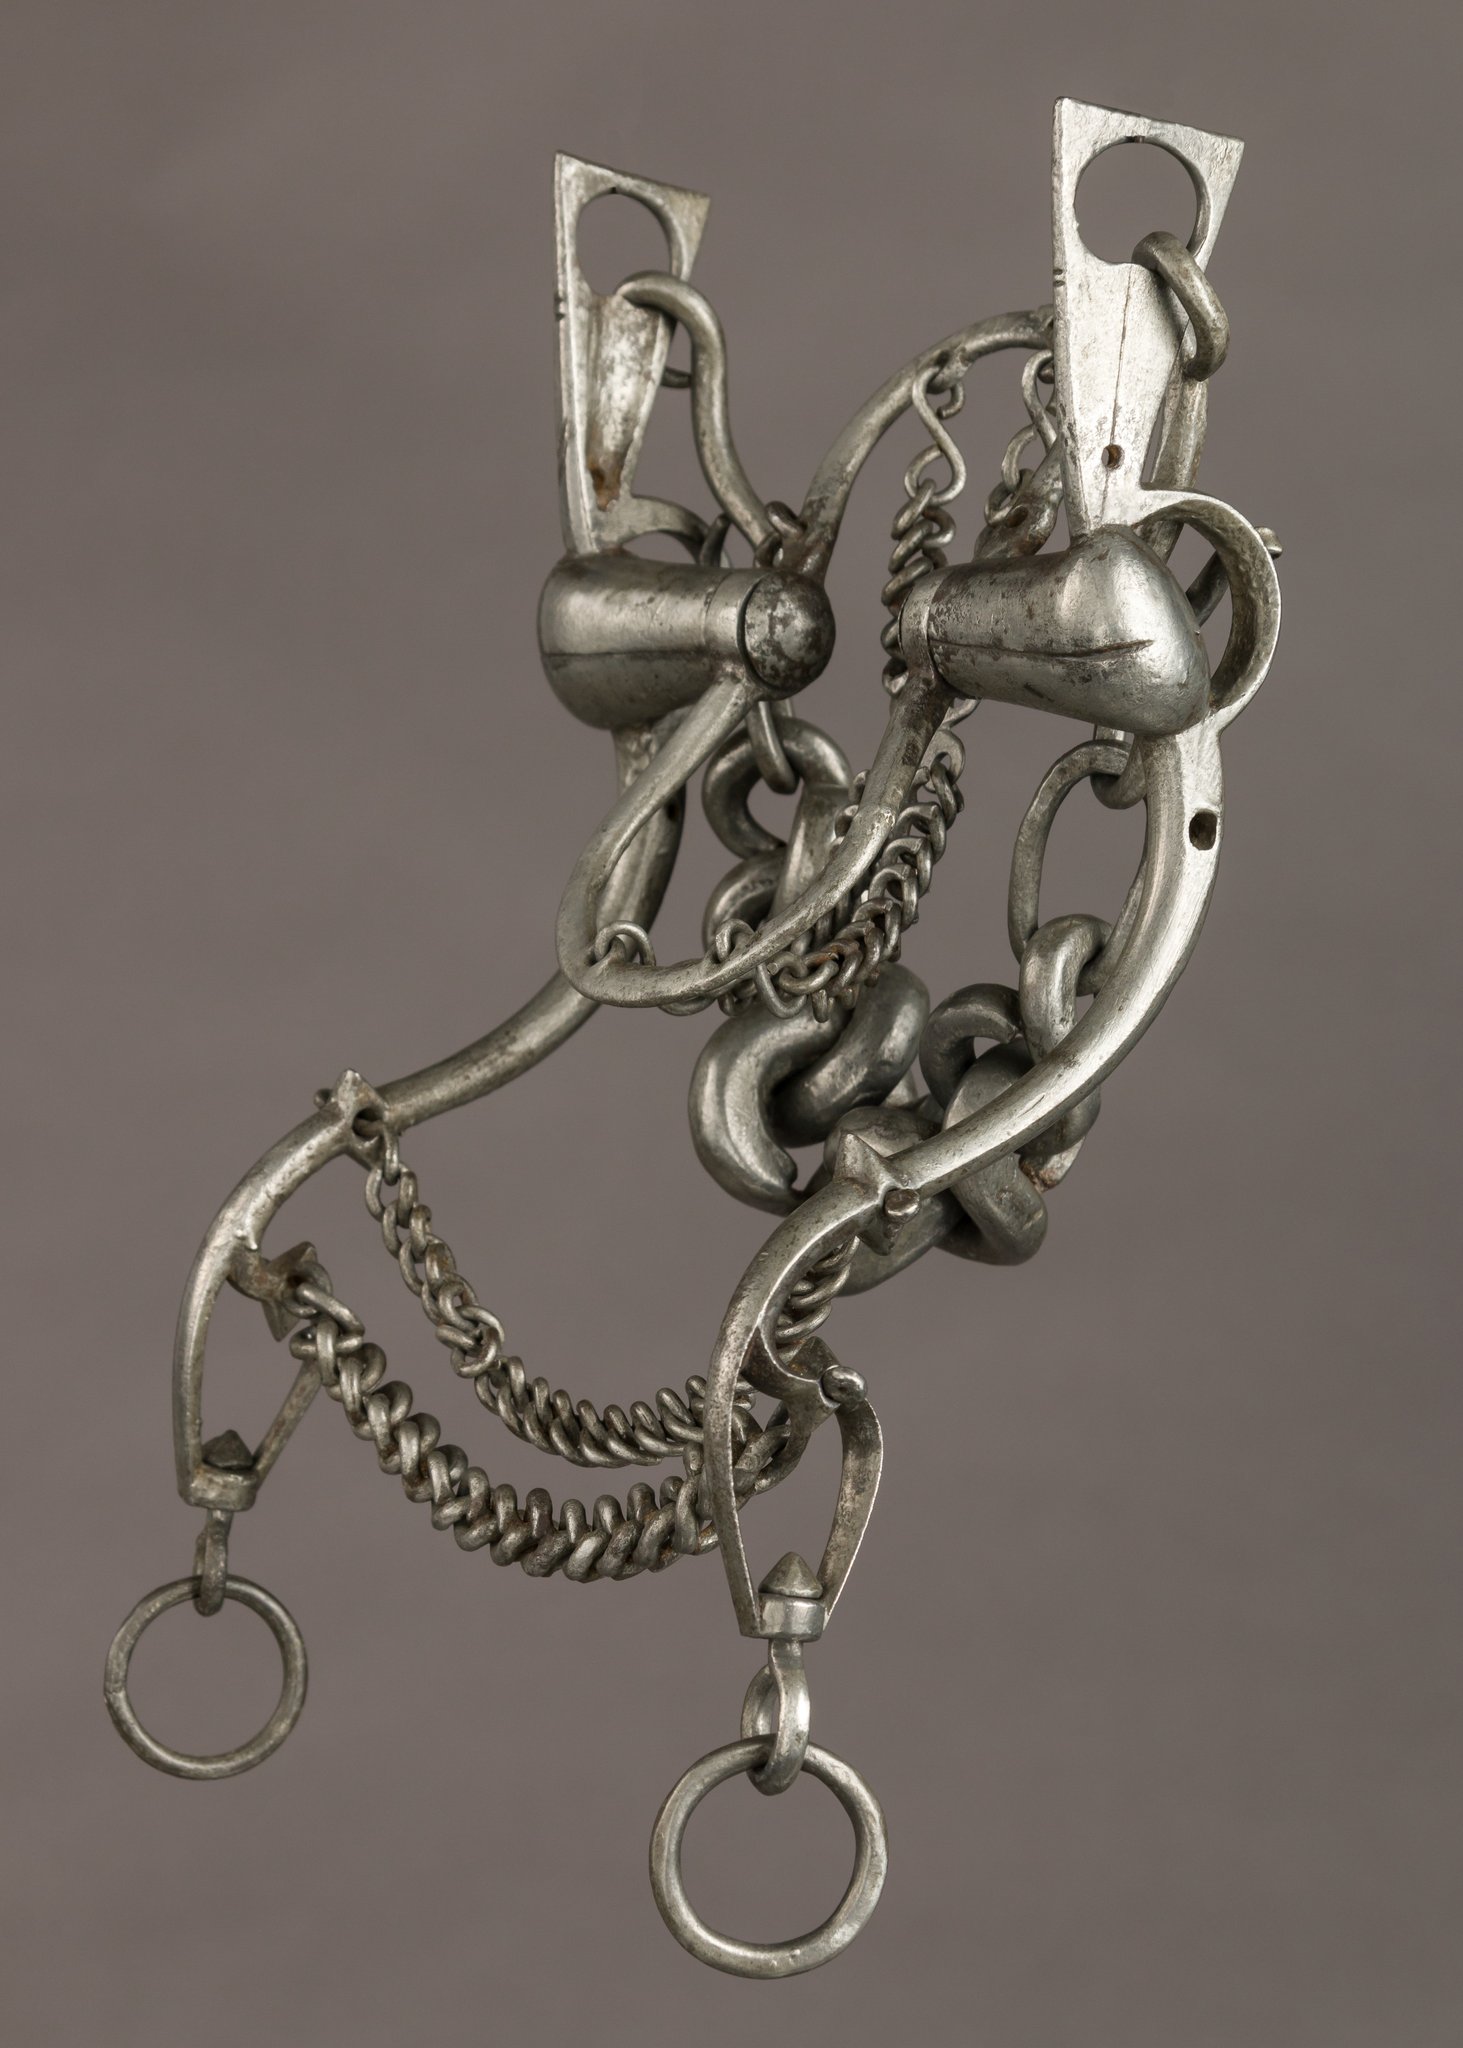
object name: bit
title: Curb Bit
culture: french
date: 1701-1800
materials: metal alloy, tin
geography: france